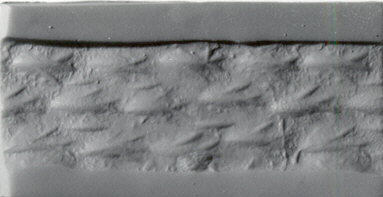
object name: cylinder seal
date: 3200-2900 BCE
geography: mesopotamia